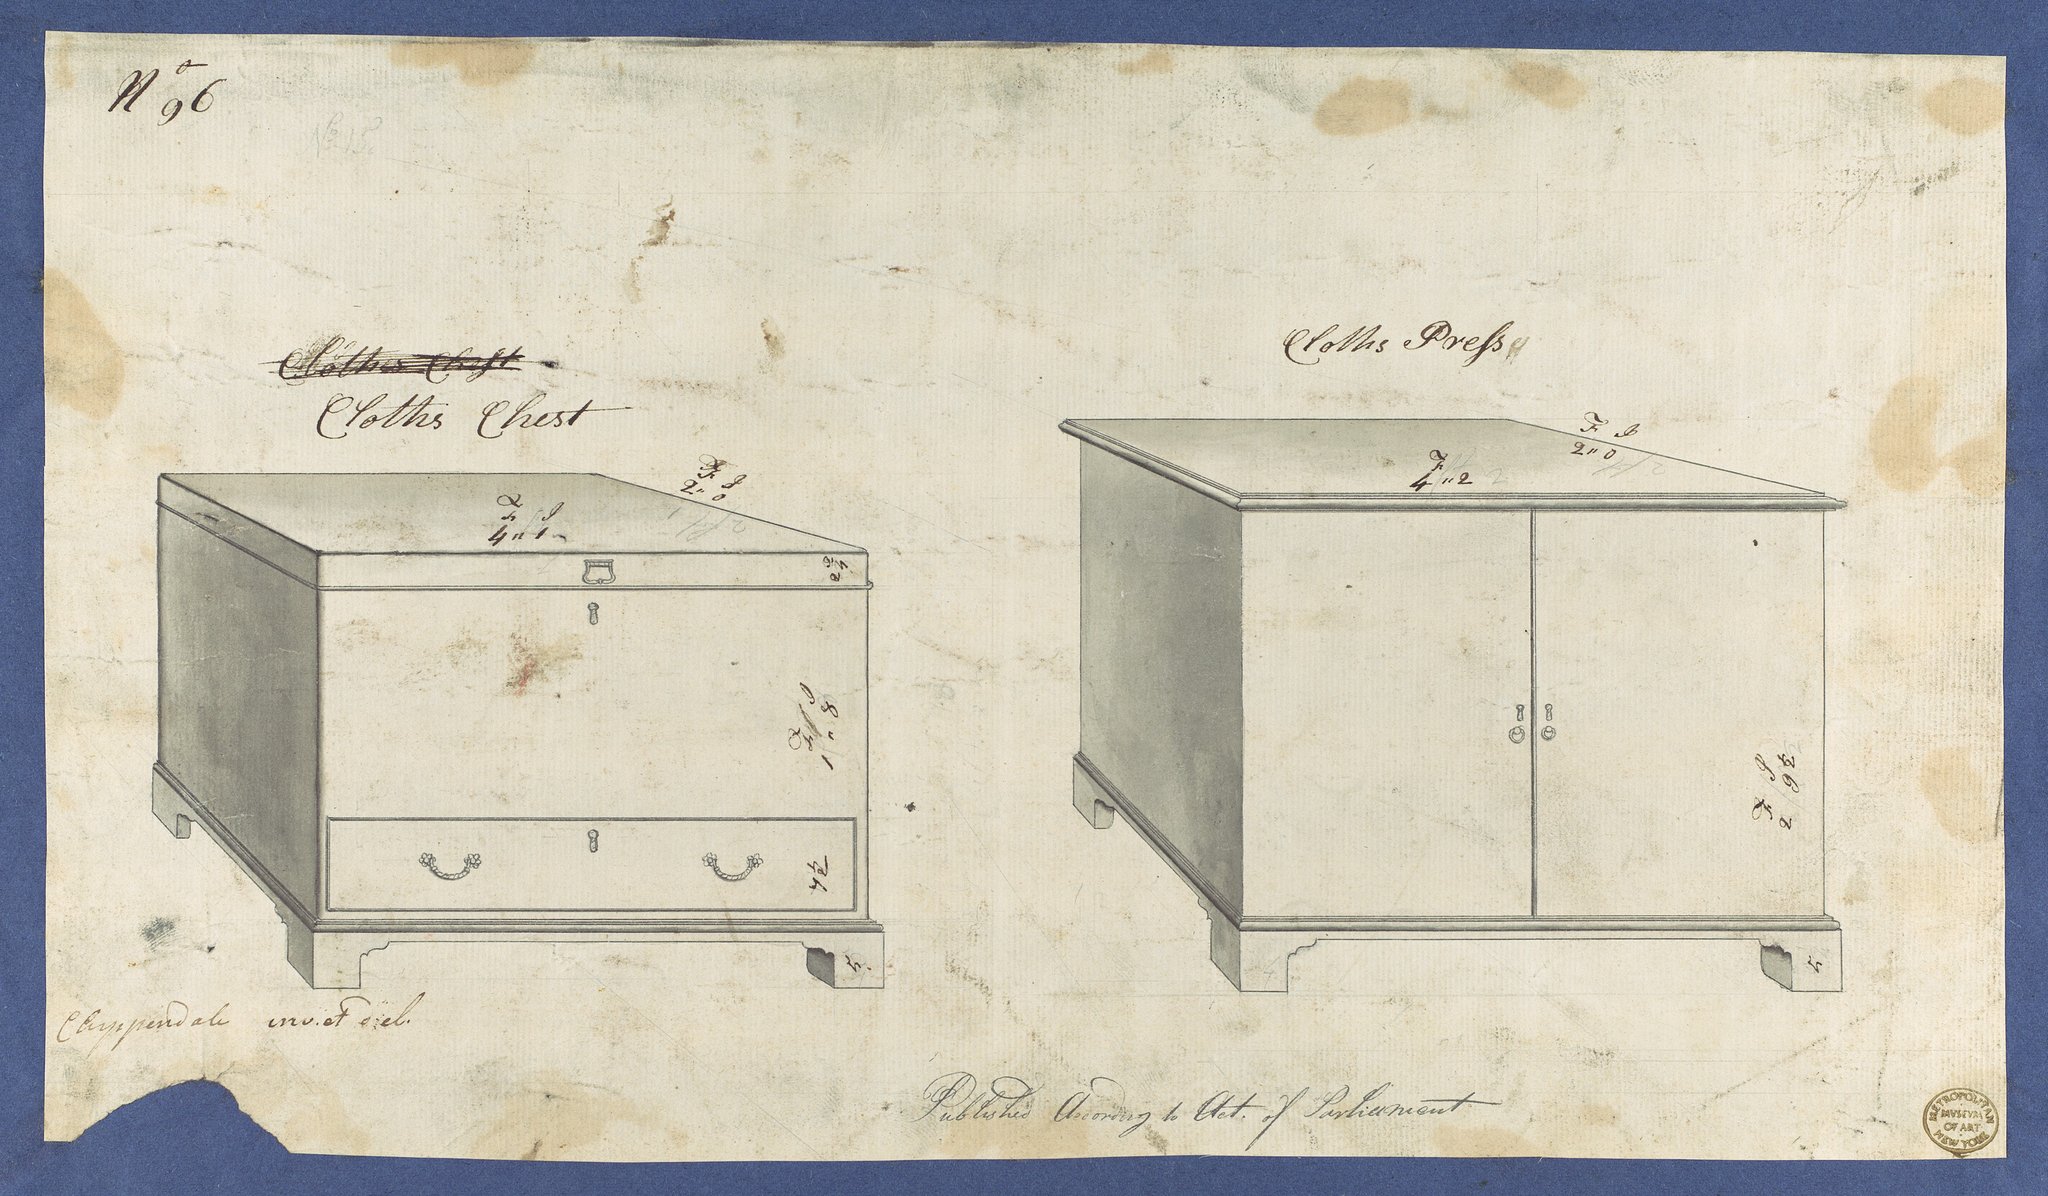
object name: drawing ornament architecture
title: Clothes Chest and Clothes Press, from Chippendale Drawings, Vol. II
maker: thomas chippendale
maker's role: artist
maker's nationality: british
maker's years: 1718-1779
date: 1754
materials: ink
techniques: wash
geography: london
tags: chests